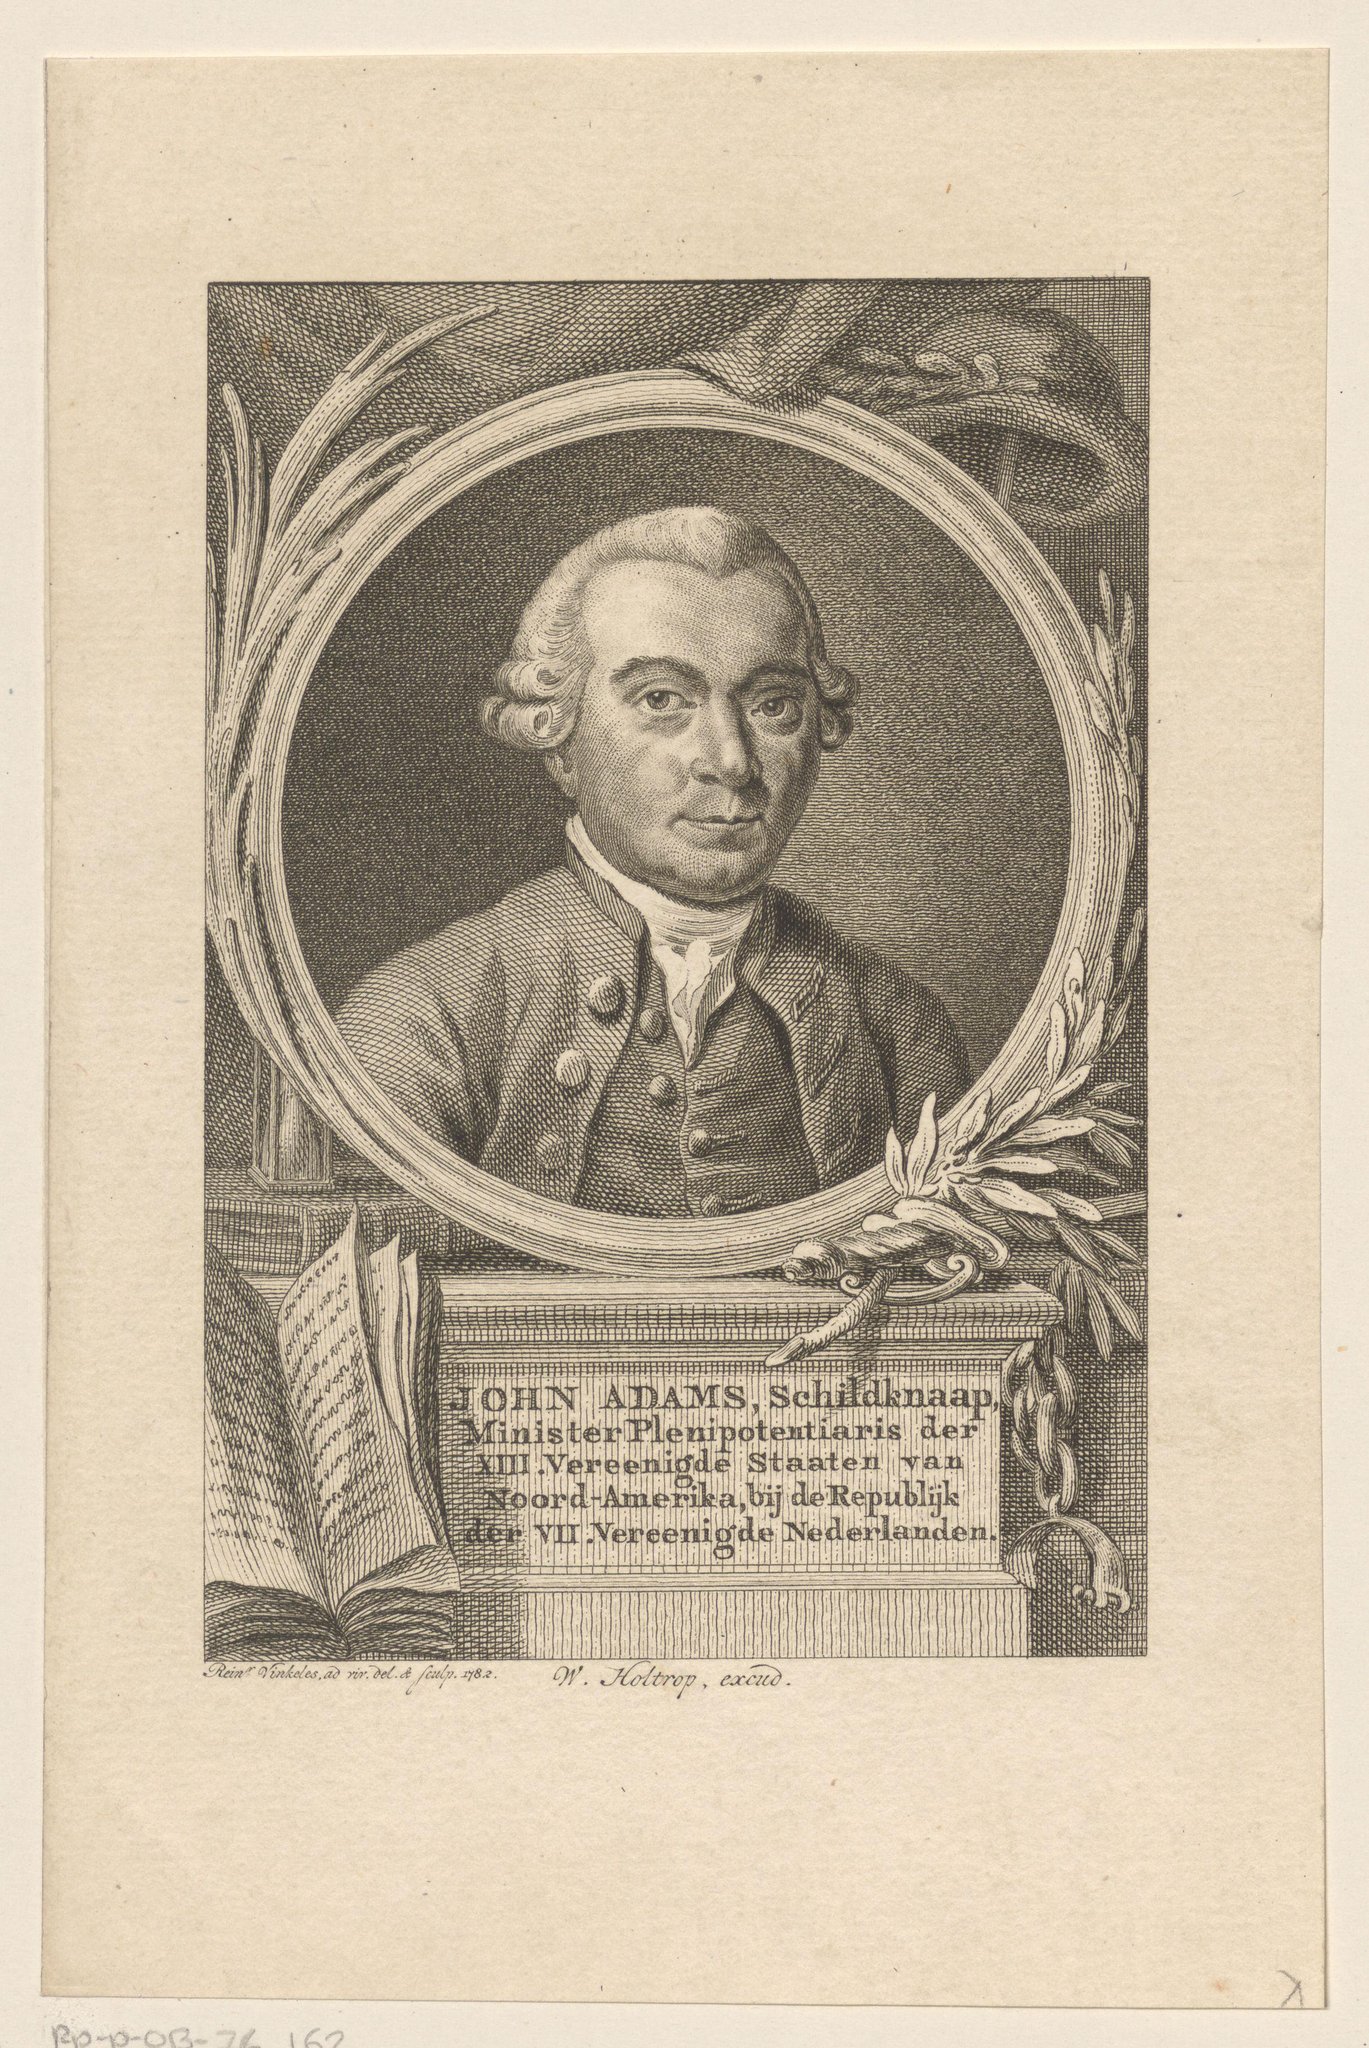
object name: print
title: Portret van John Adams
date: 1782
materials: paper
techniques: engraving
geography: amsterdam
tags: braintree, president, diplomaat, john adams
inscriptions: date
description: Portret van John Adams in een cirkelvormige omlijsting. Daar omheen een aantal allegorische objecten. In een kader zijn naam en beroep.